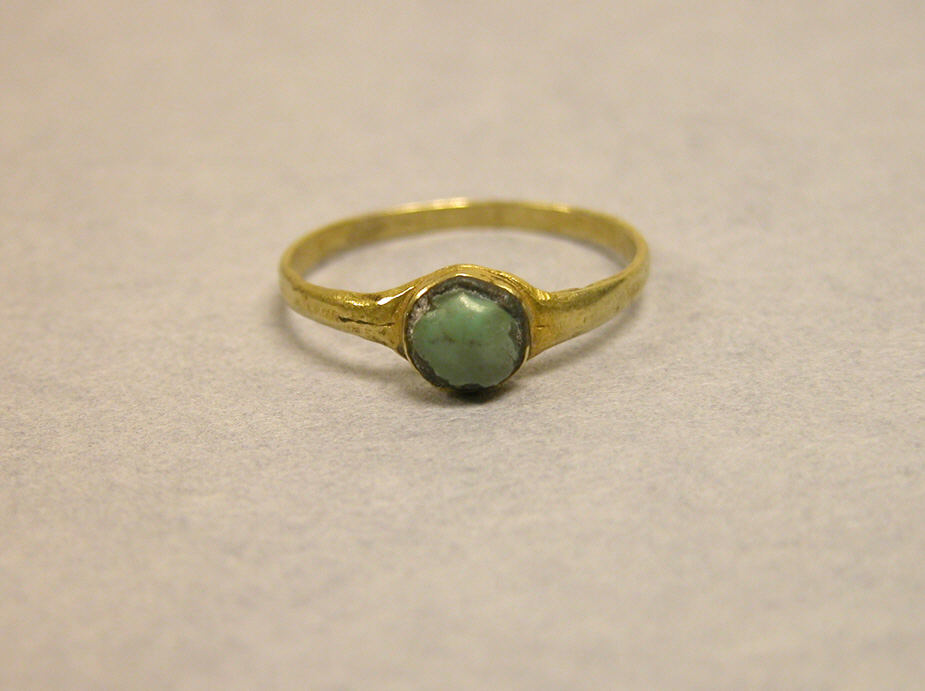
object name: ring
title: Ring with Stone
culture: indonesian, central java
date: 701-1200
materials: gold